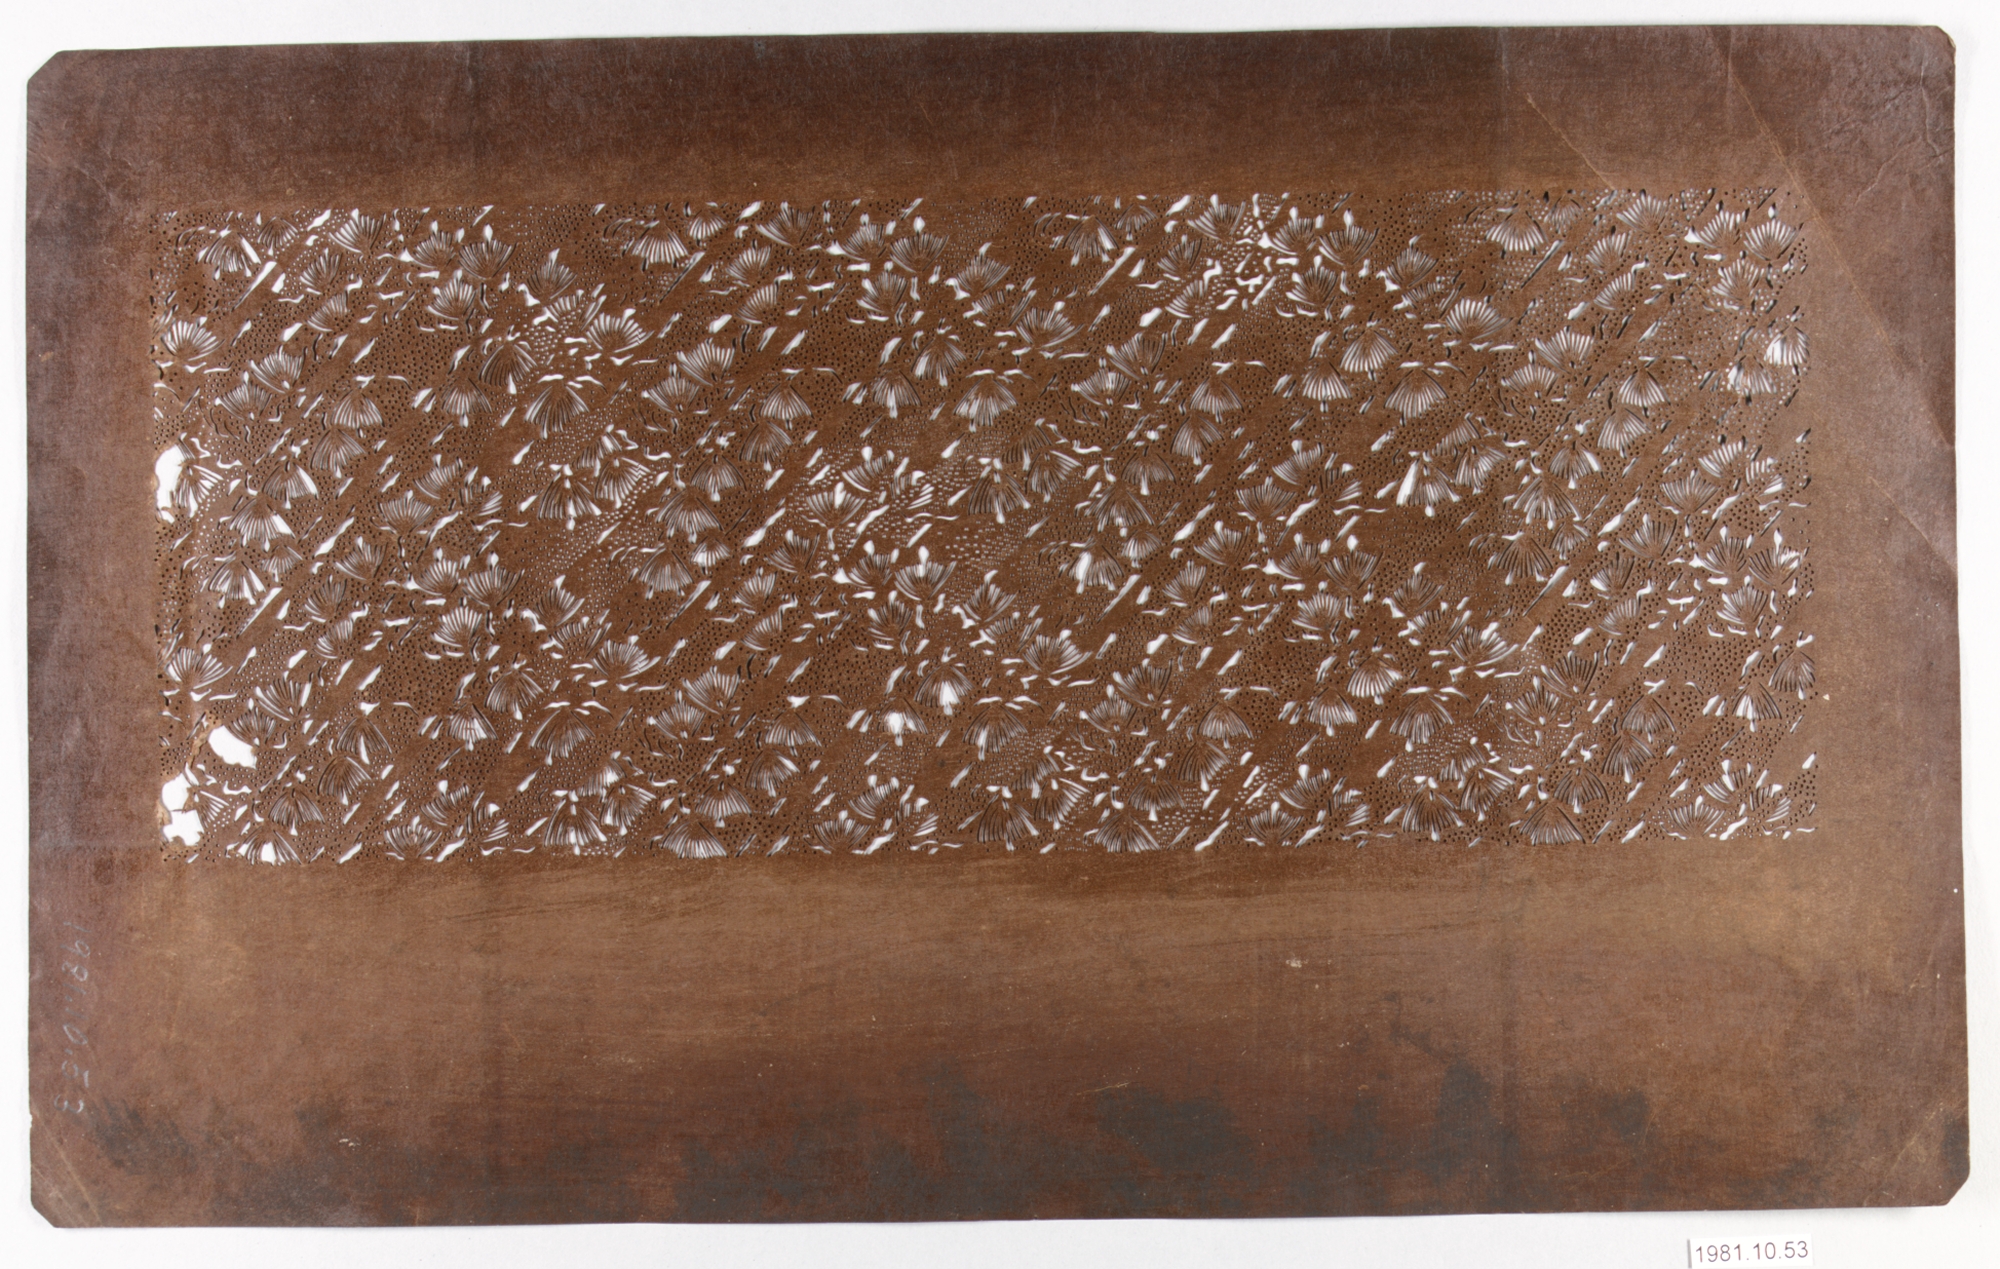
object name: stencil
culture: japanese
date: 1801-1900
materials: paper